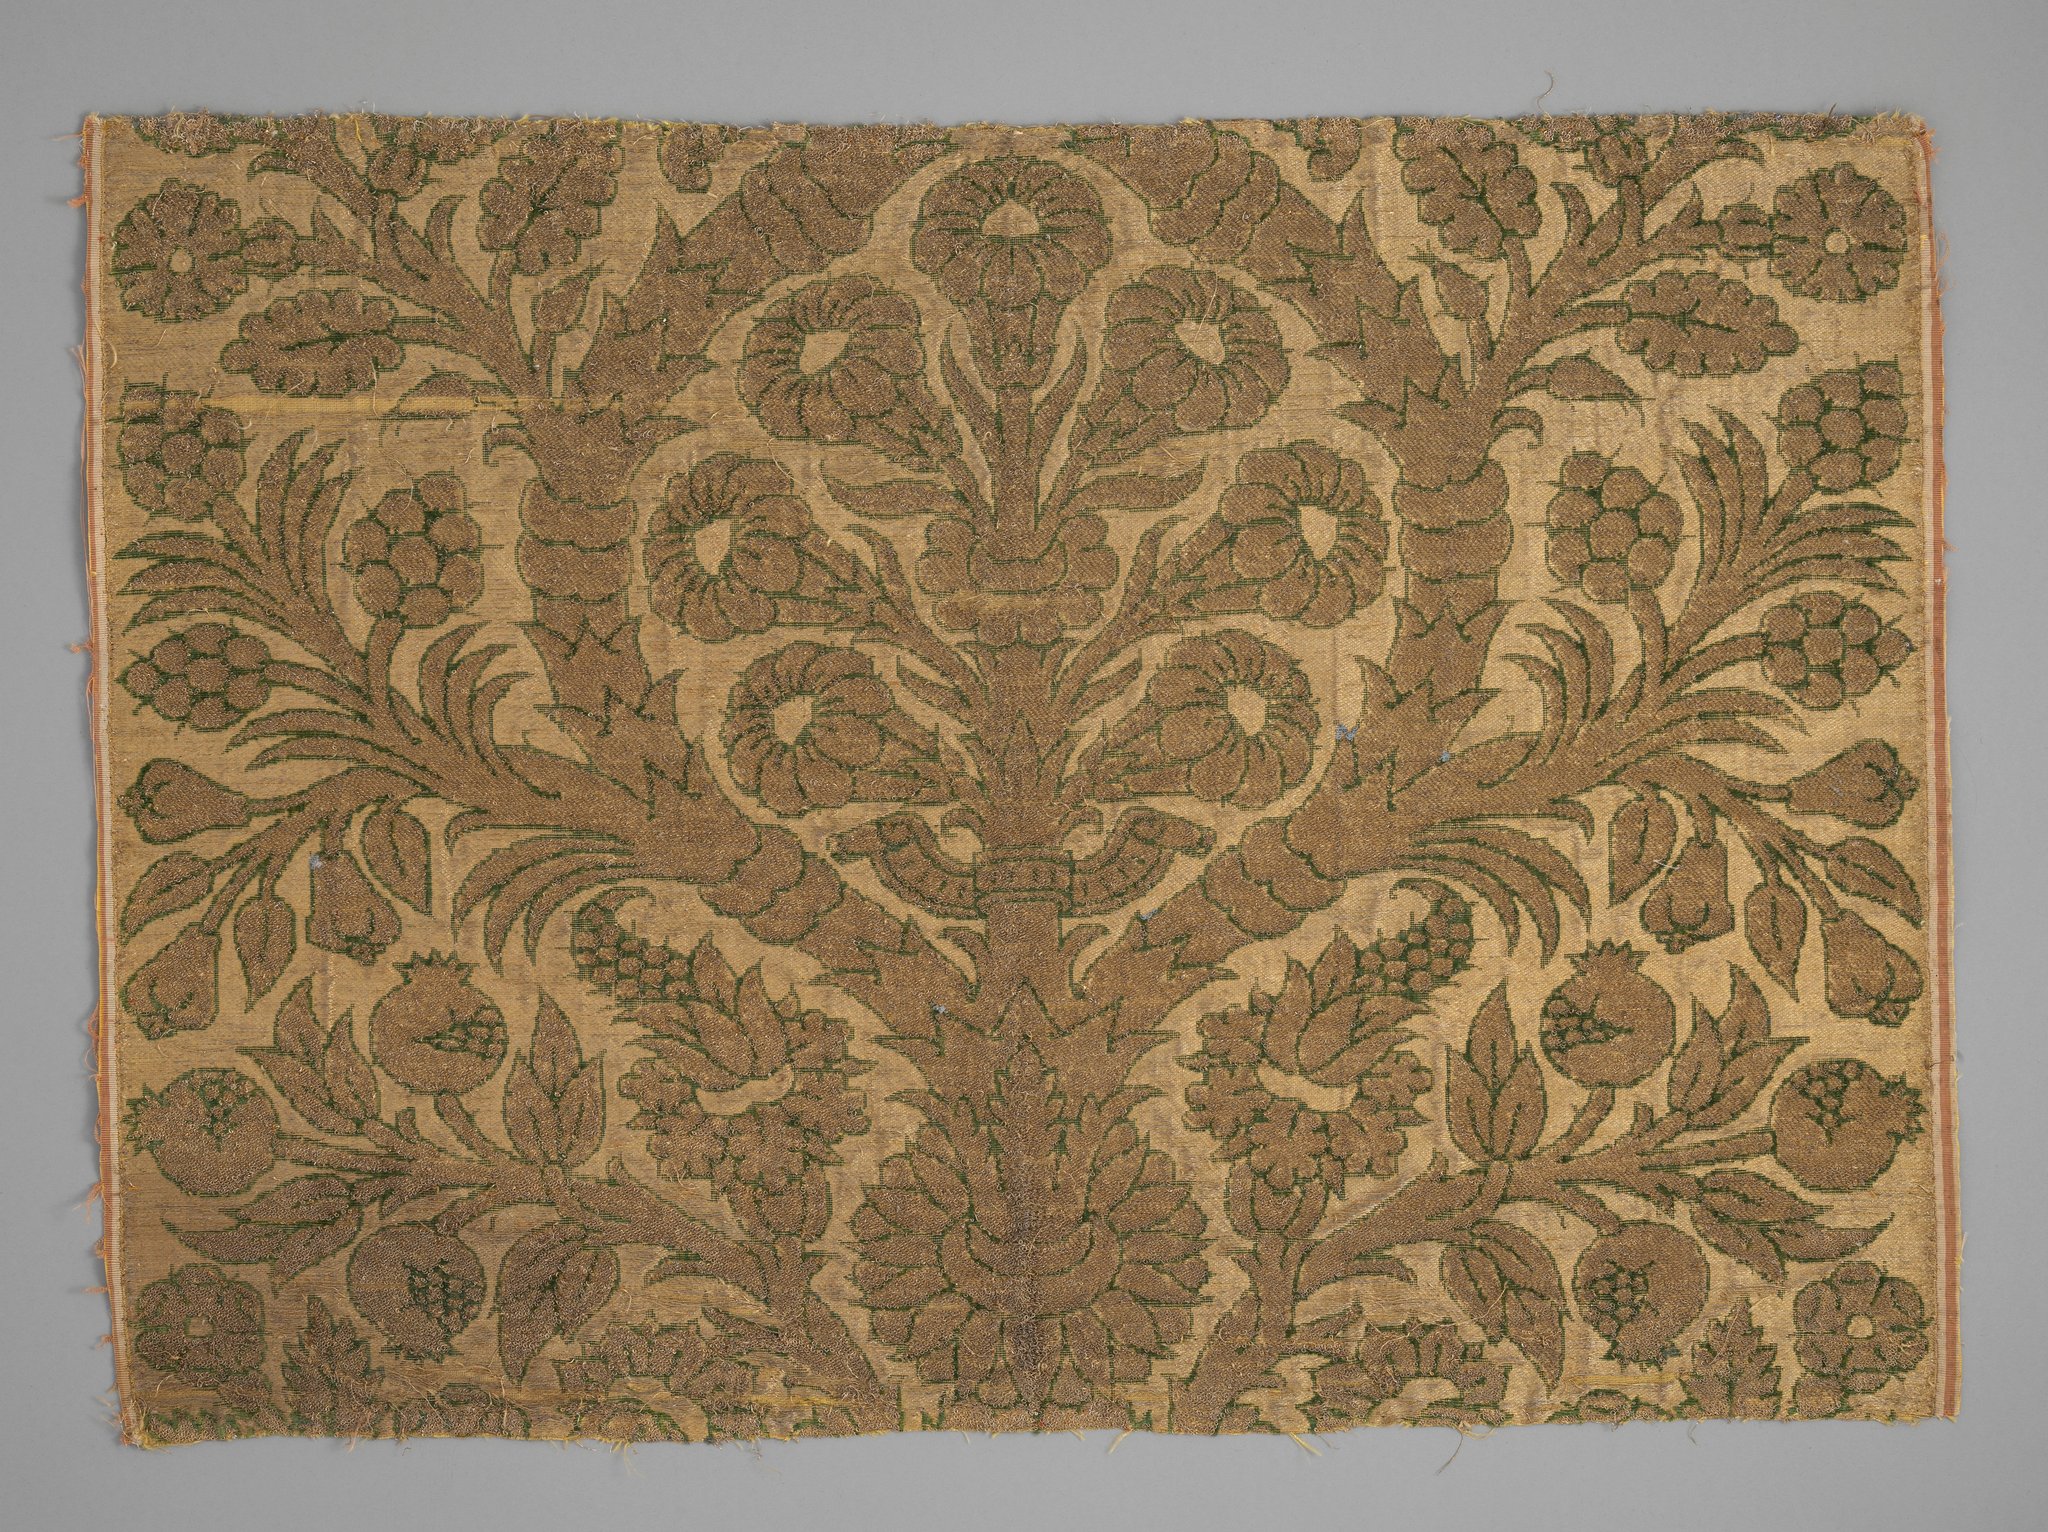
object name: piece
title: Fragment with Sempervivum tectorum motif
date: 1475-1525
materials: metal thread, silk